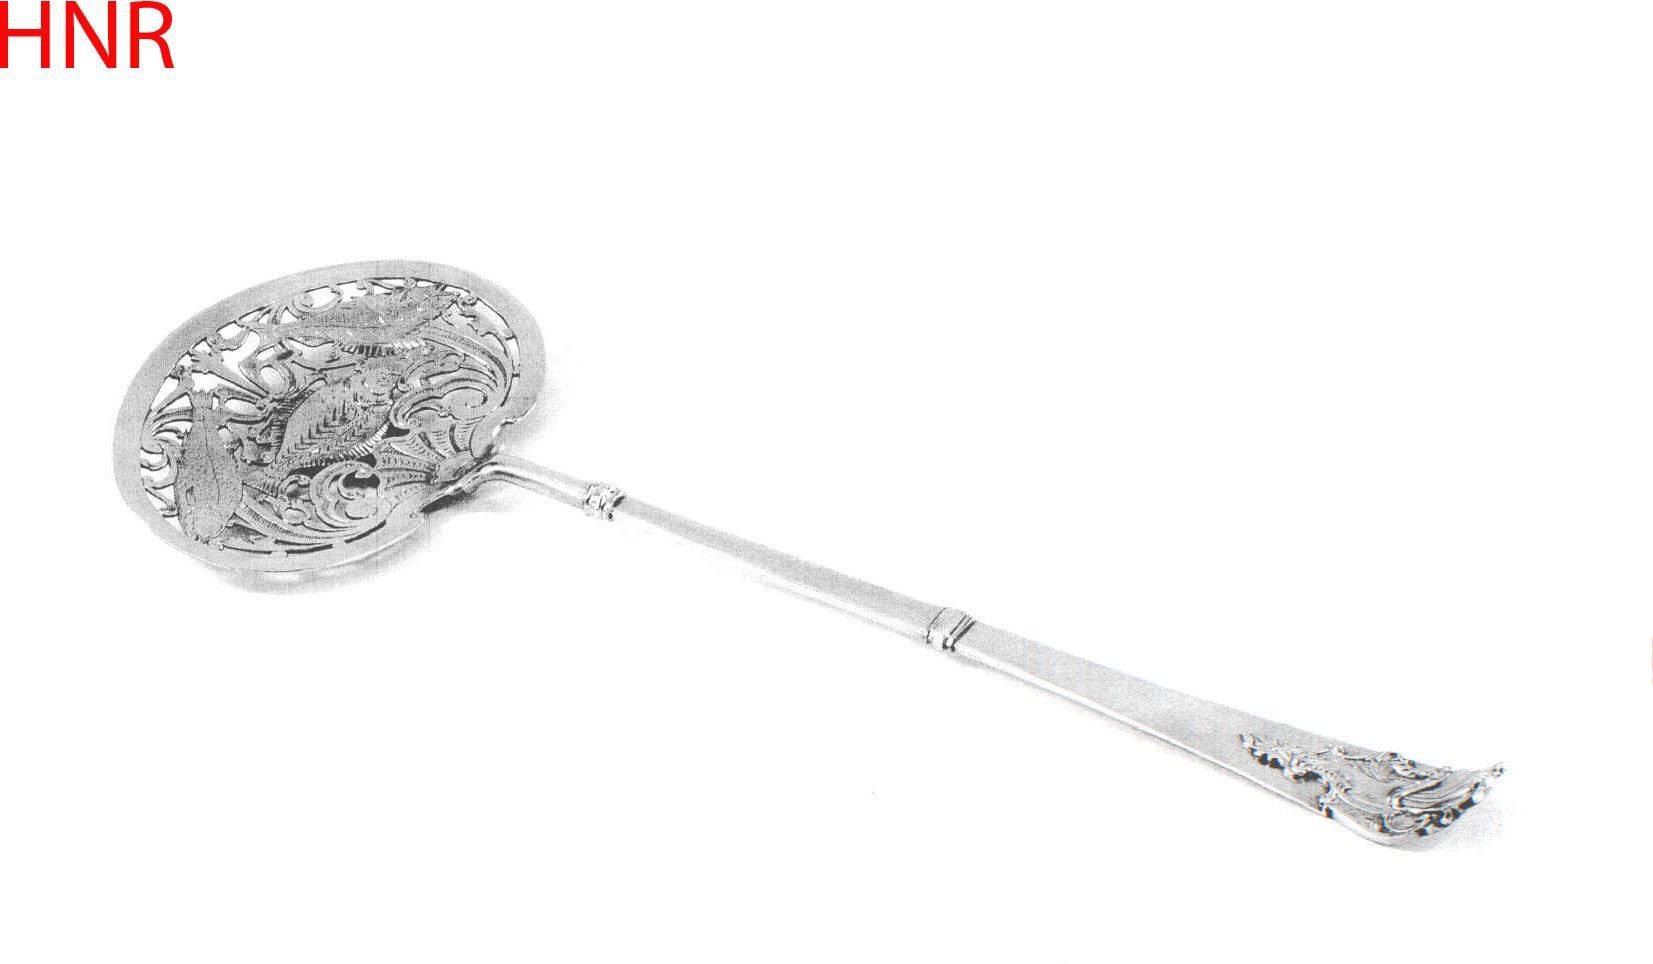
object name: visschep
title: Visschep met drie vissen tegen een achtergrond van bandwerk met bladmotieven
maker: willem pont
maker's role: silversmith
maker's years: 1734-1797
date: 1771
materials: silver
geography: amsterdam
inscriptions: duty mark, town mark, maker's mark, alloy mark: ‘Hollandse leeuw’, date letter: ‘M’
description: Fish slice. Silver. Amsterdam, 1771, by Willem Pont.